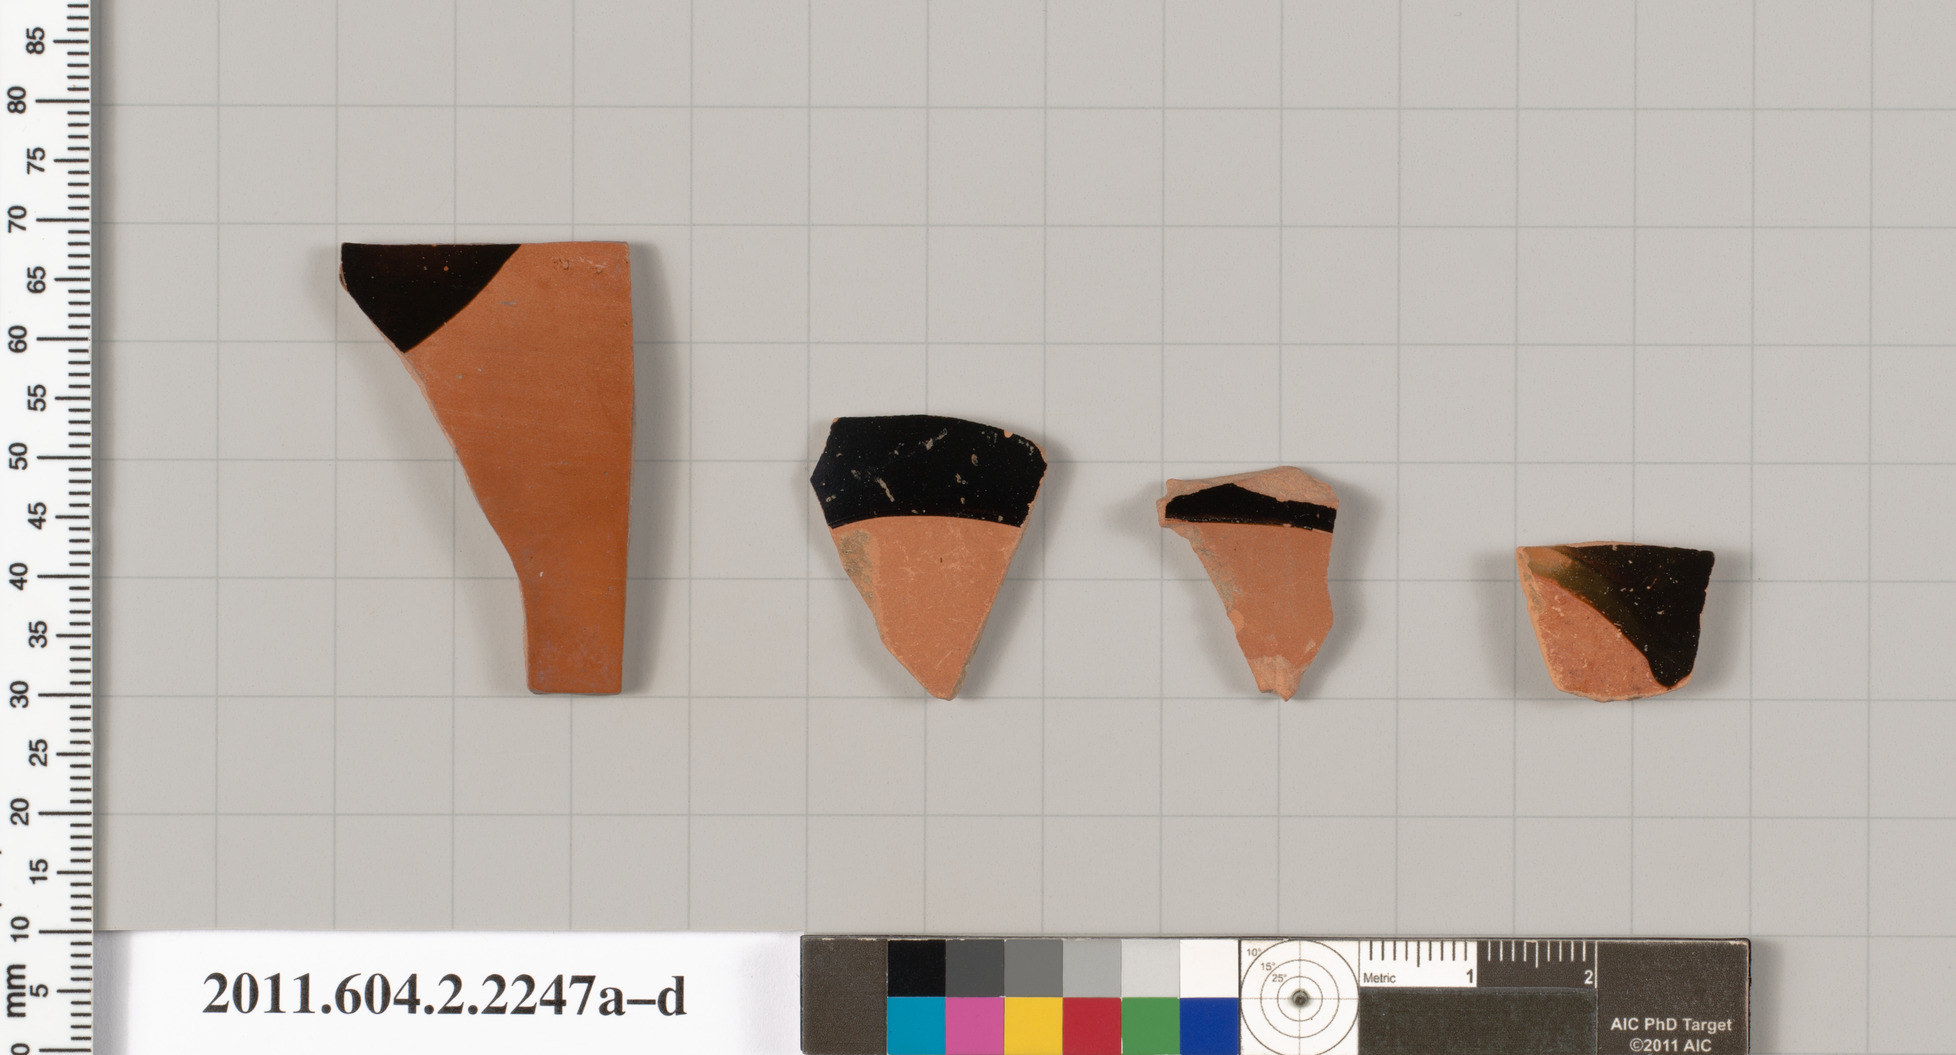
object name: pot fragment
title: Terracotta fragments of pots; unglazed on the inside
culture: greek, attic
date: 475-425 BCE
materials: terracotta